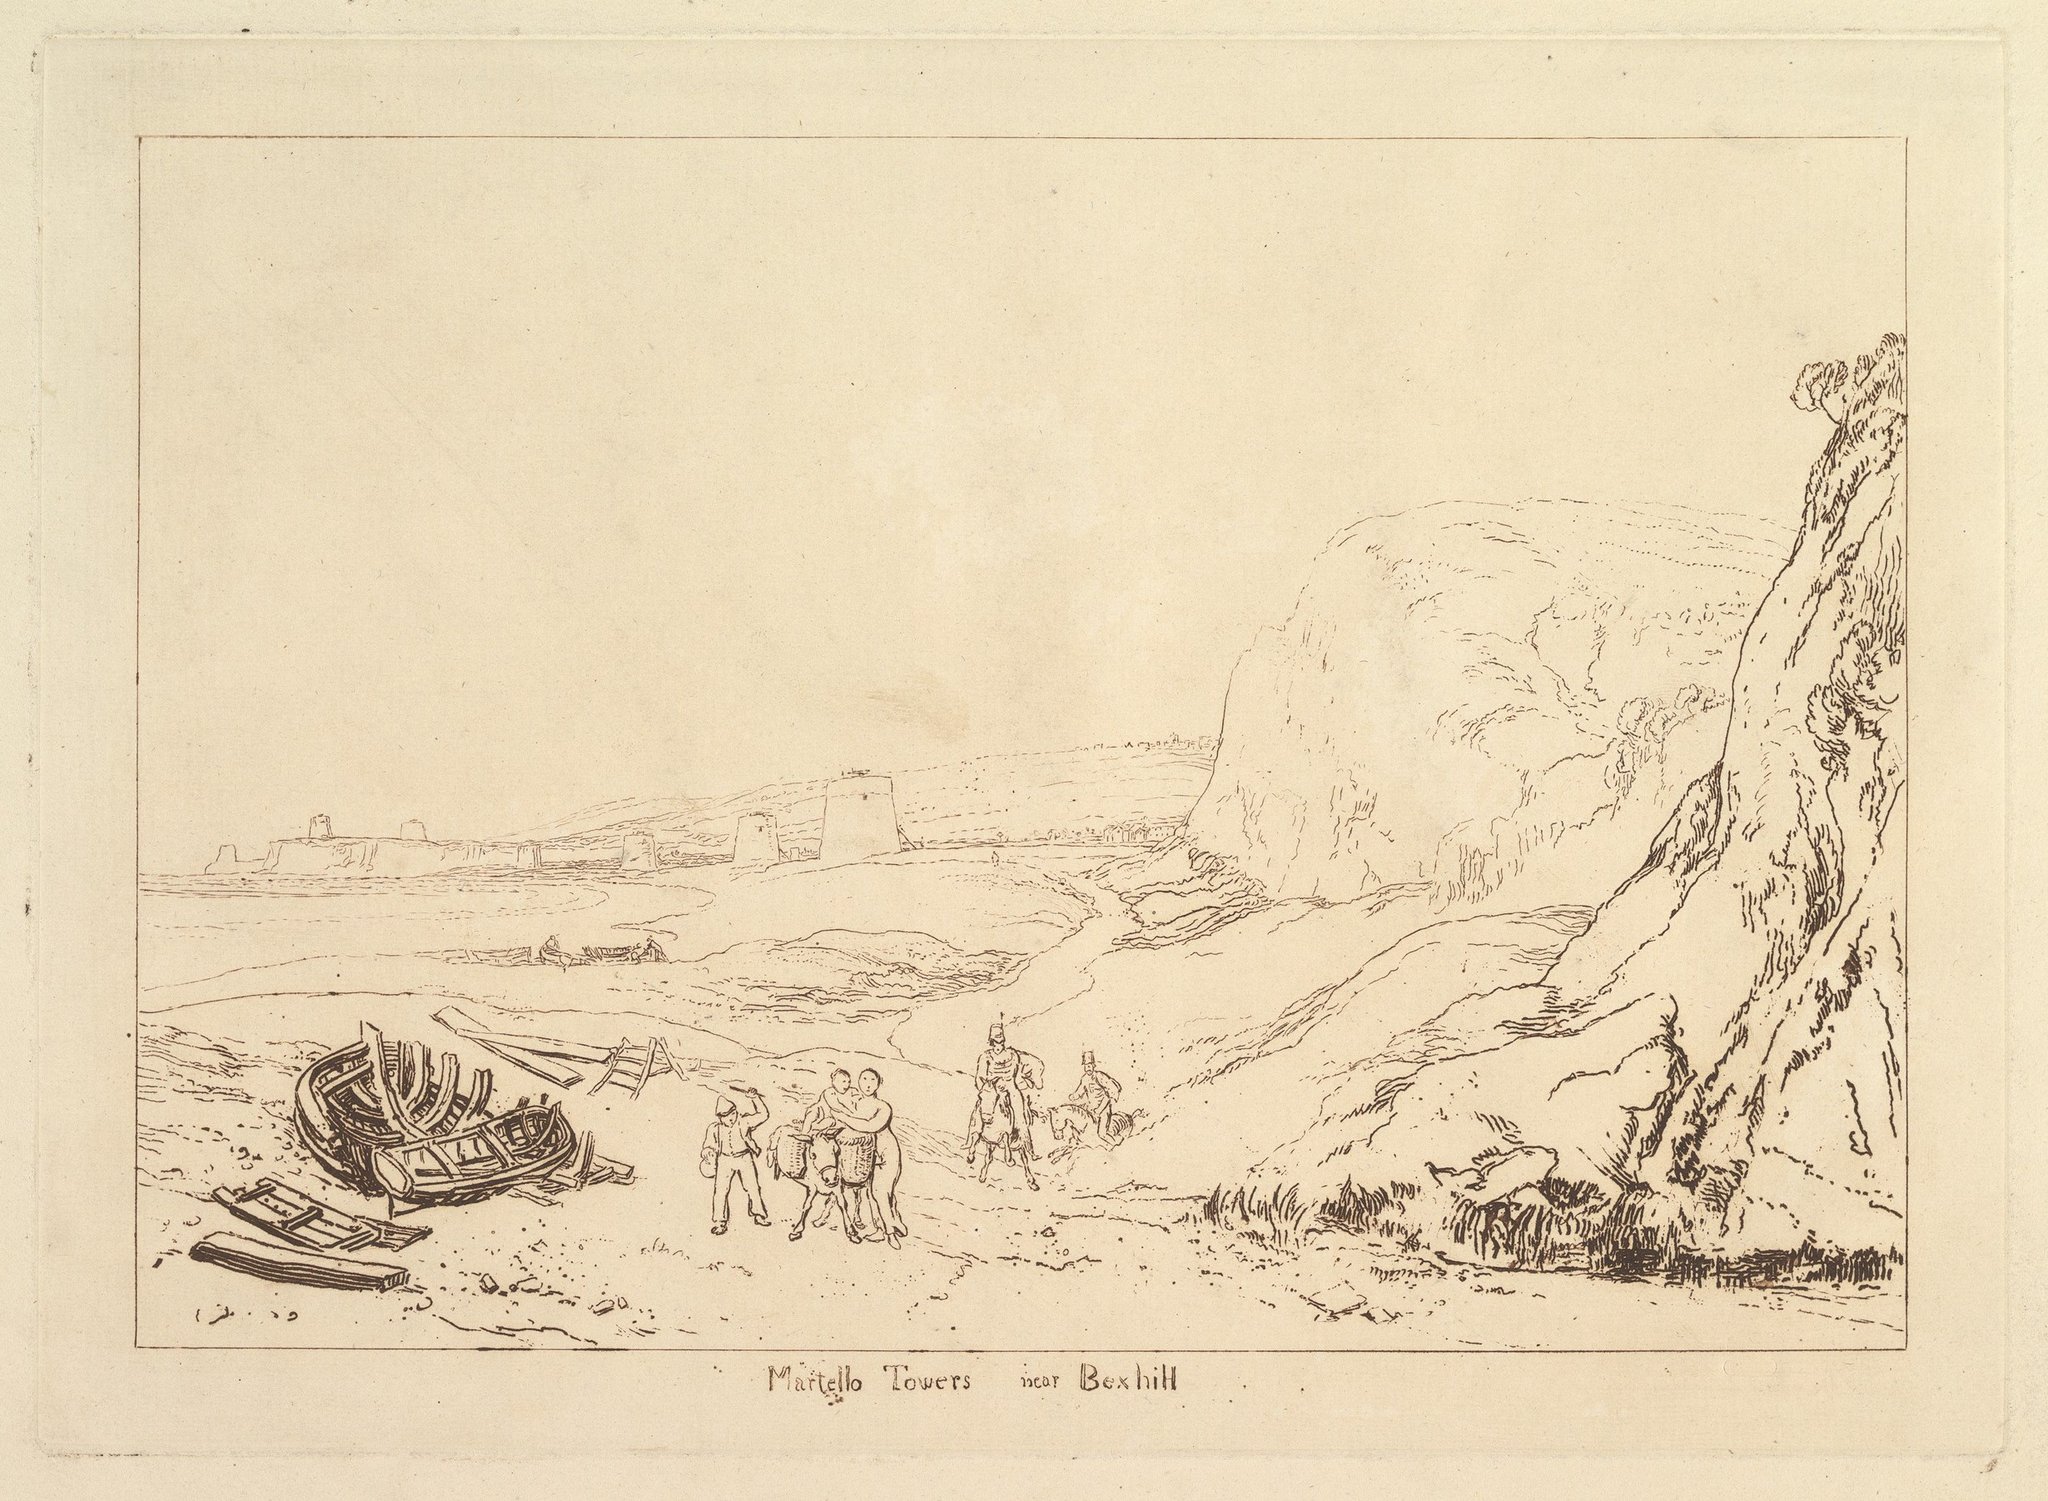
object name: print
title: Martello Towers near Bexhill, Sussex (Liber Studiorum, part VII, plate 34)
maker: joseph mallord william turner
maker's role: artist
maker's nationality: british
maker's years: 1775-1851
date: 1811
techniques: etching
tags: towers,men,women,donkeys,boats